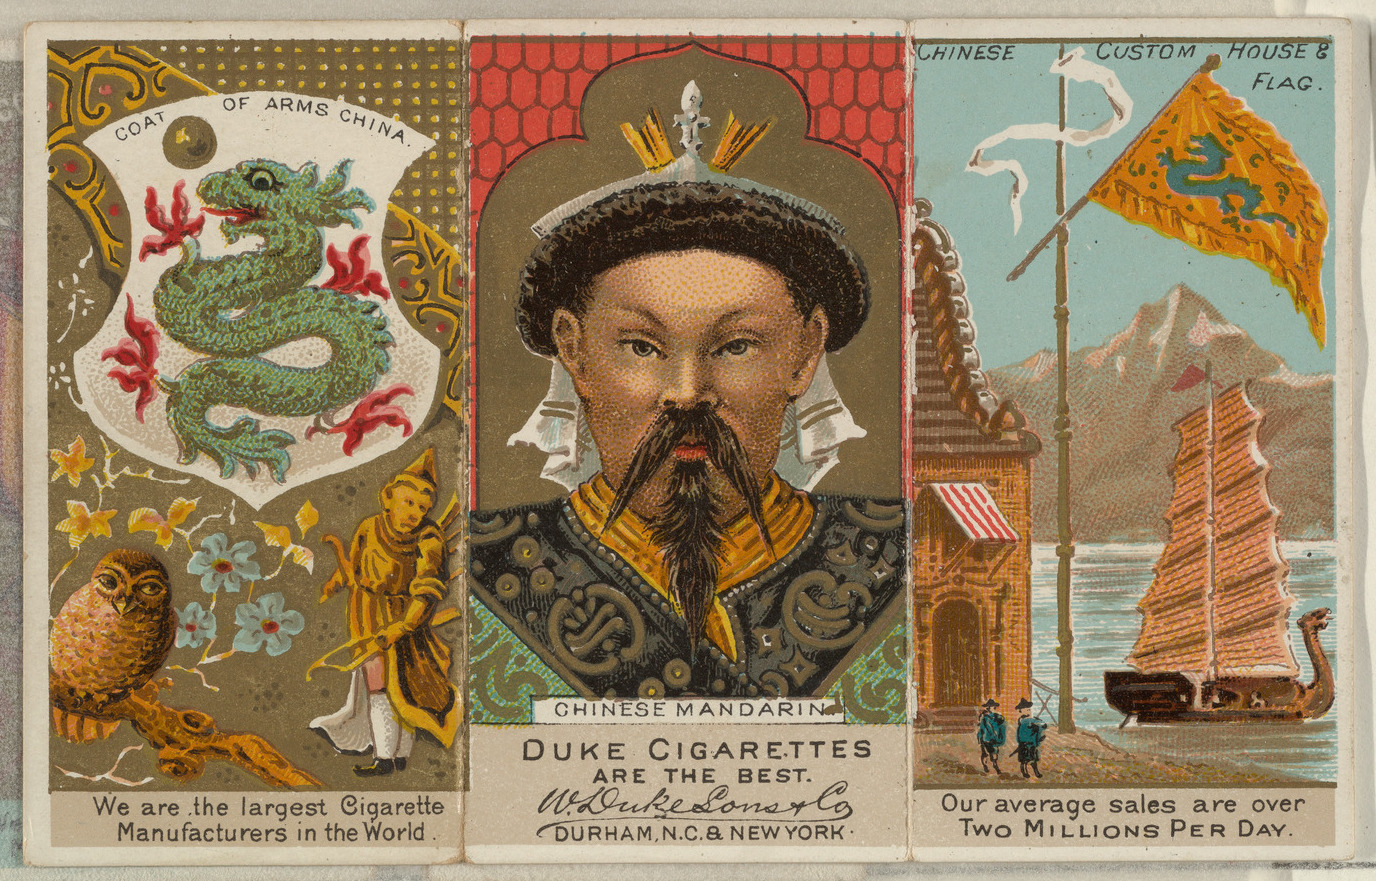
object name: print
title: Chinese Mandarin, from the Rulers, Flags, and Coats of Arms series (N126-2) issued by W. Duke, Sons & Co.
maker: w. duke, sons & co.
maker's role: publisher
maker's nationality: american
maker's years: 1870-1920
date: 1888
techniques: color lithograph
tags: men,portraits,dragons,coat of arms,flags